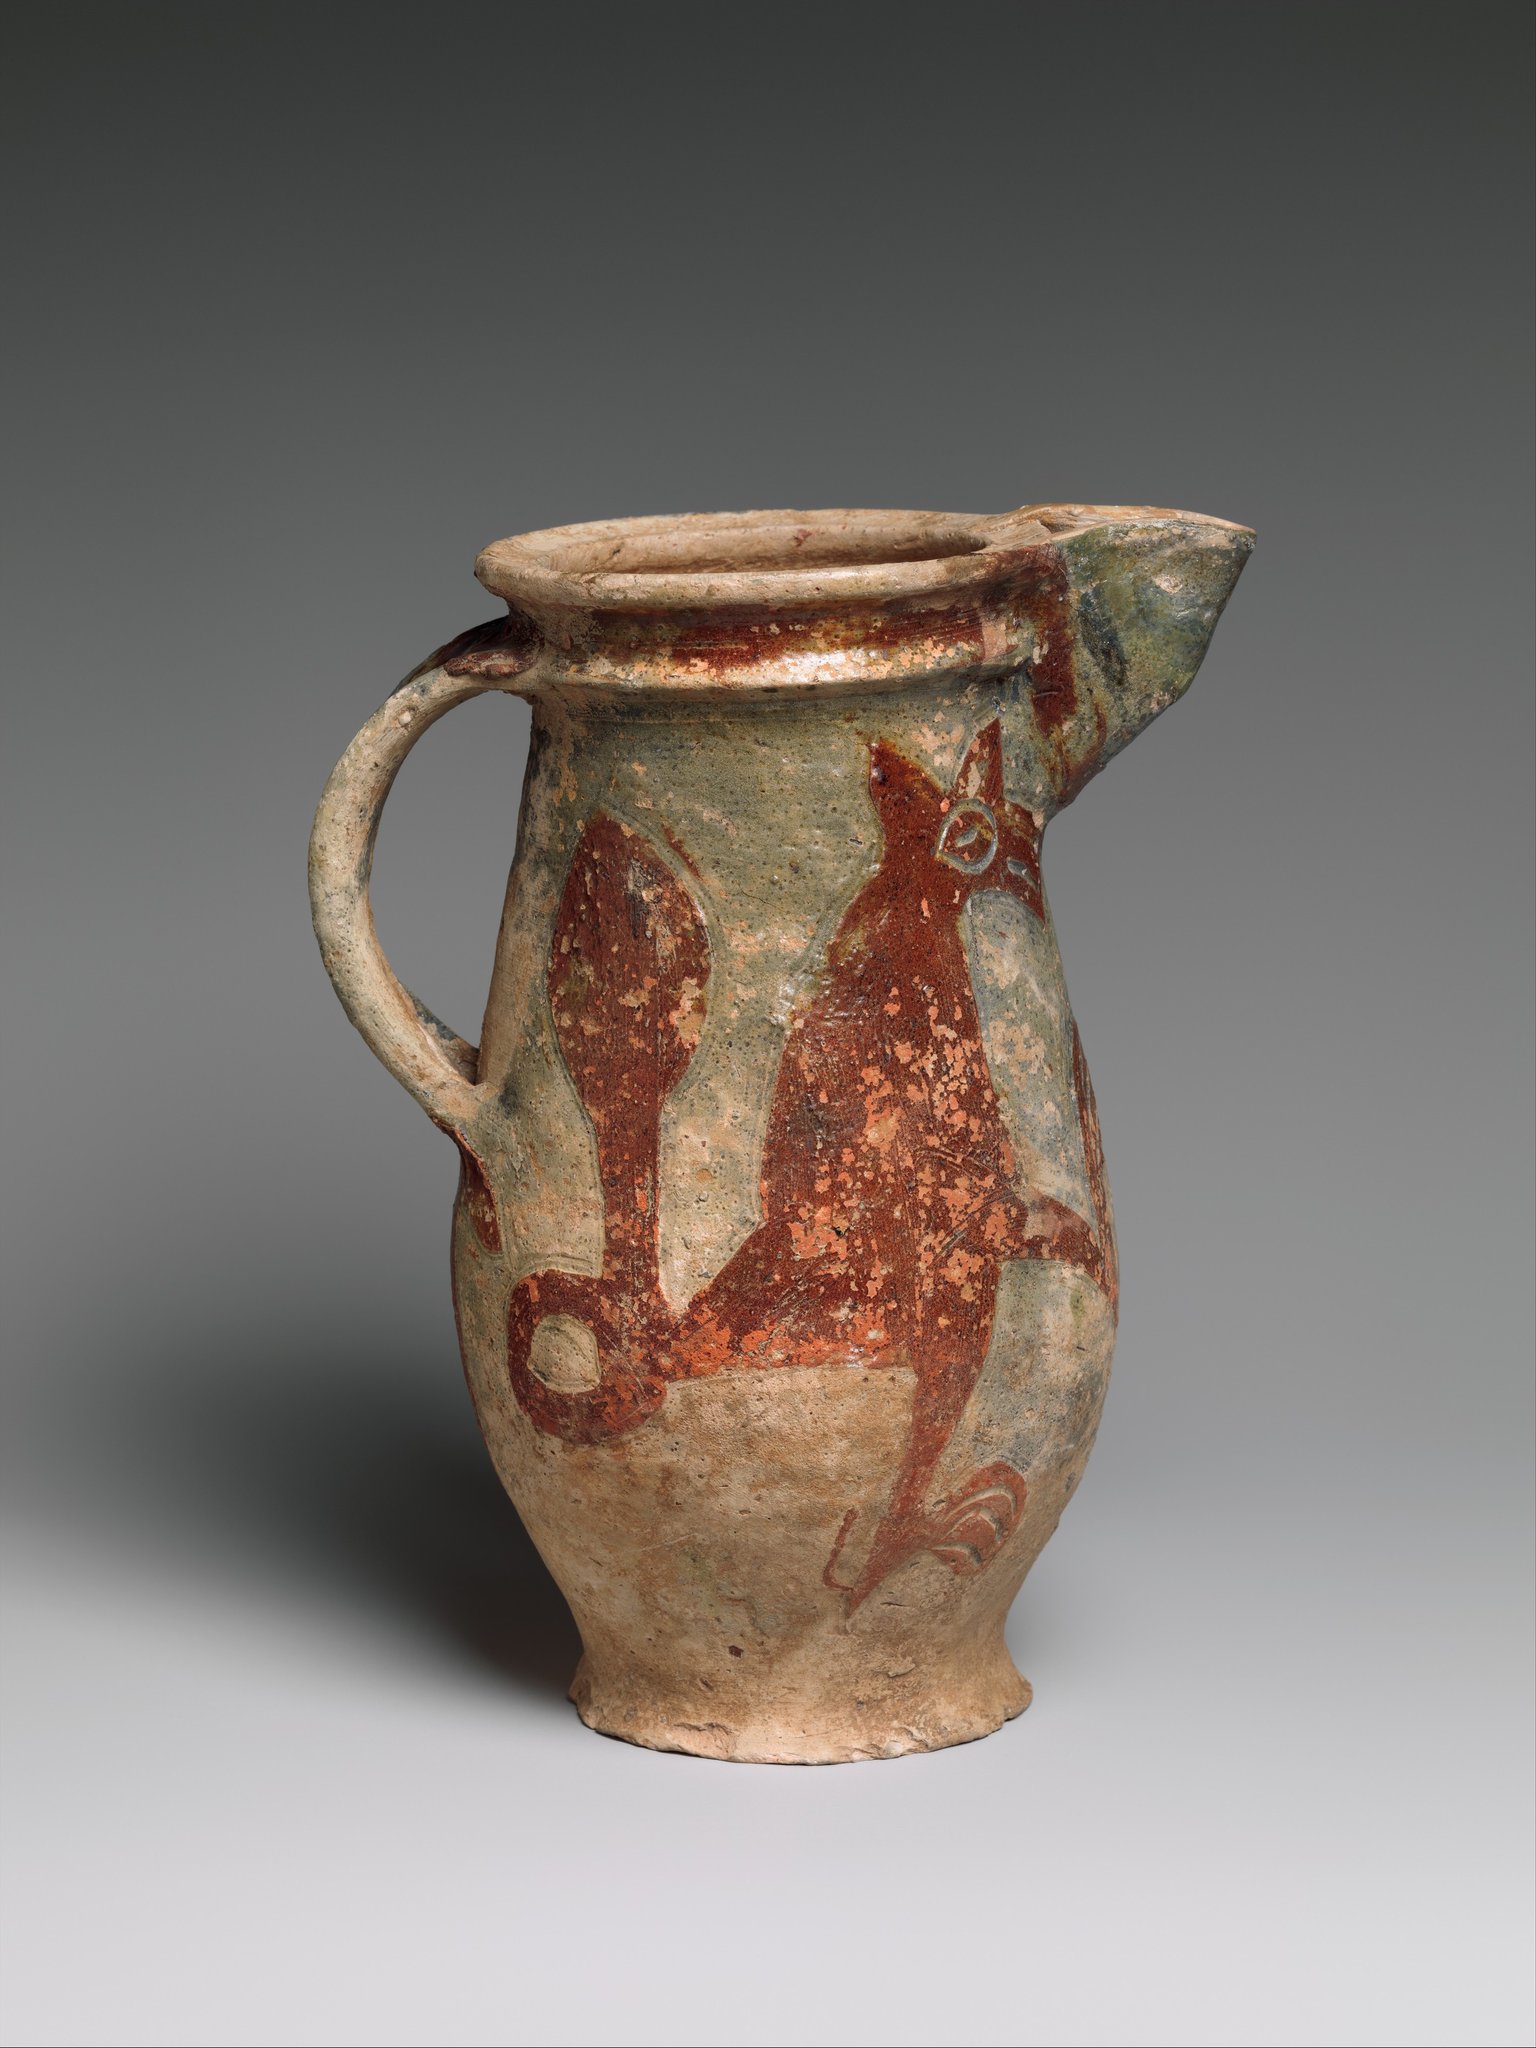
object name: jug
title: Barrel-Shaped Jug with a Fox and a Rooster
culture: french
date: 1267-1300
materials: earthenware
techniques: glazing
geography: france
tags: roosters,foxes